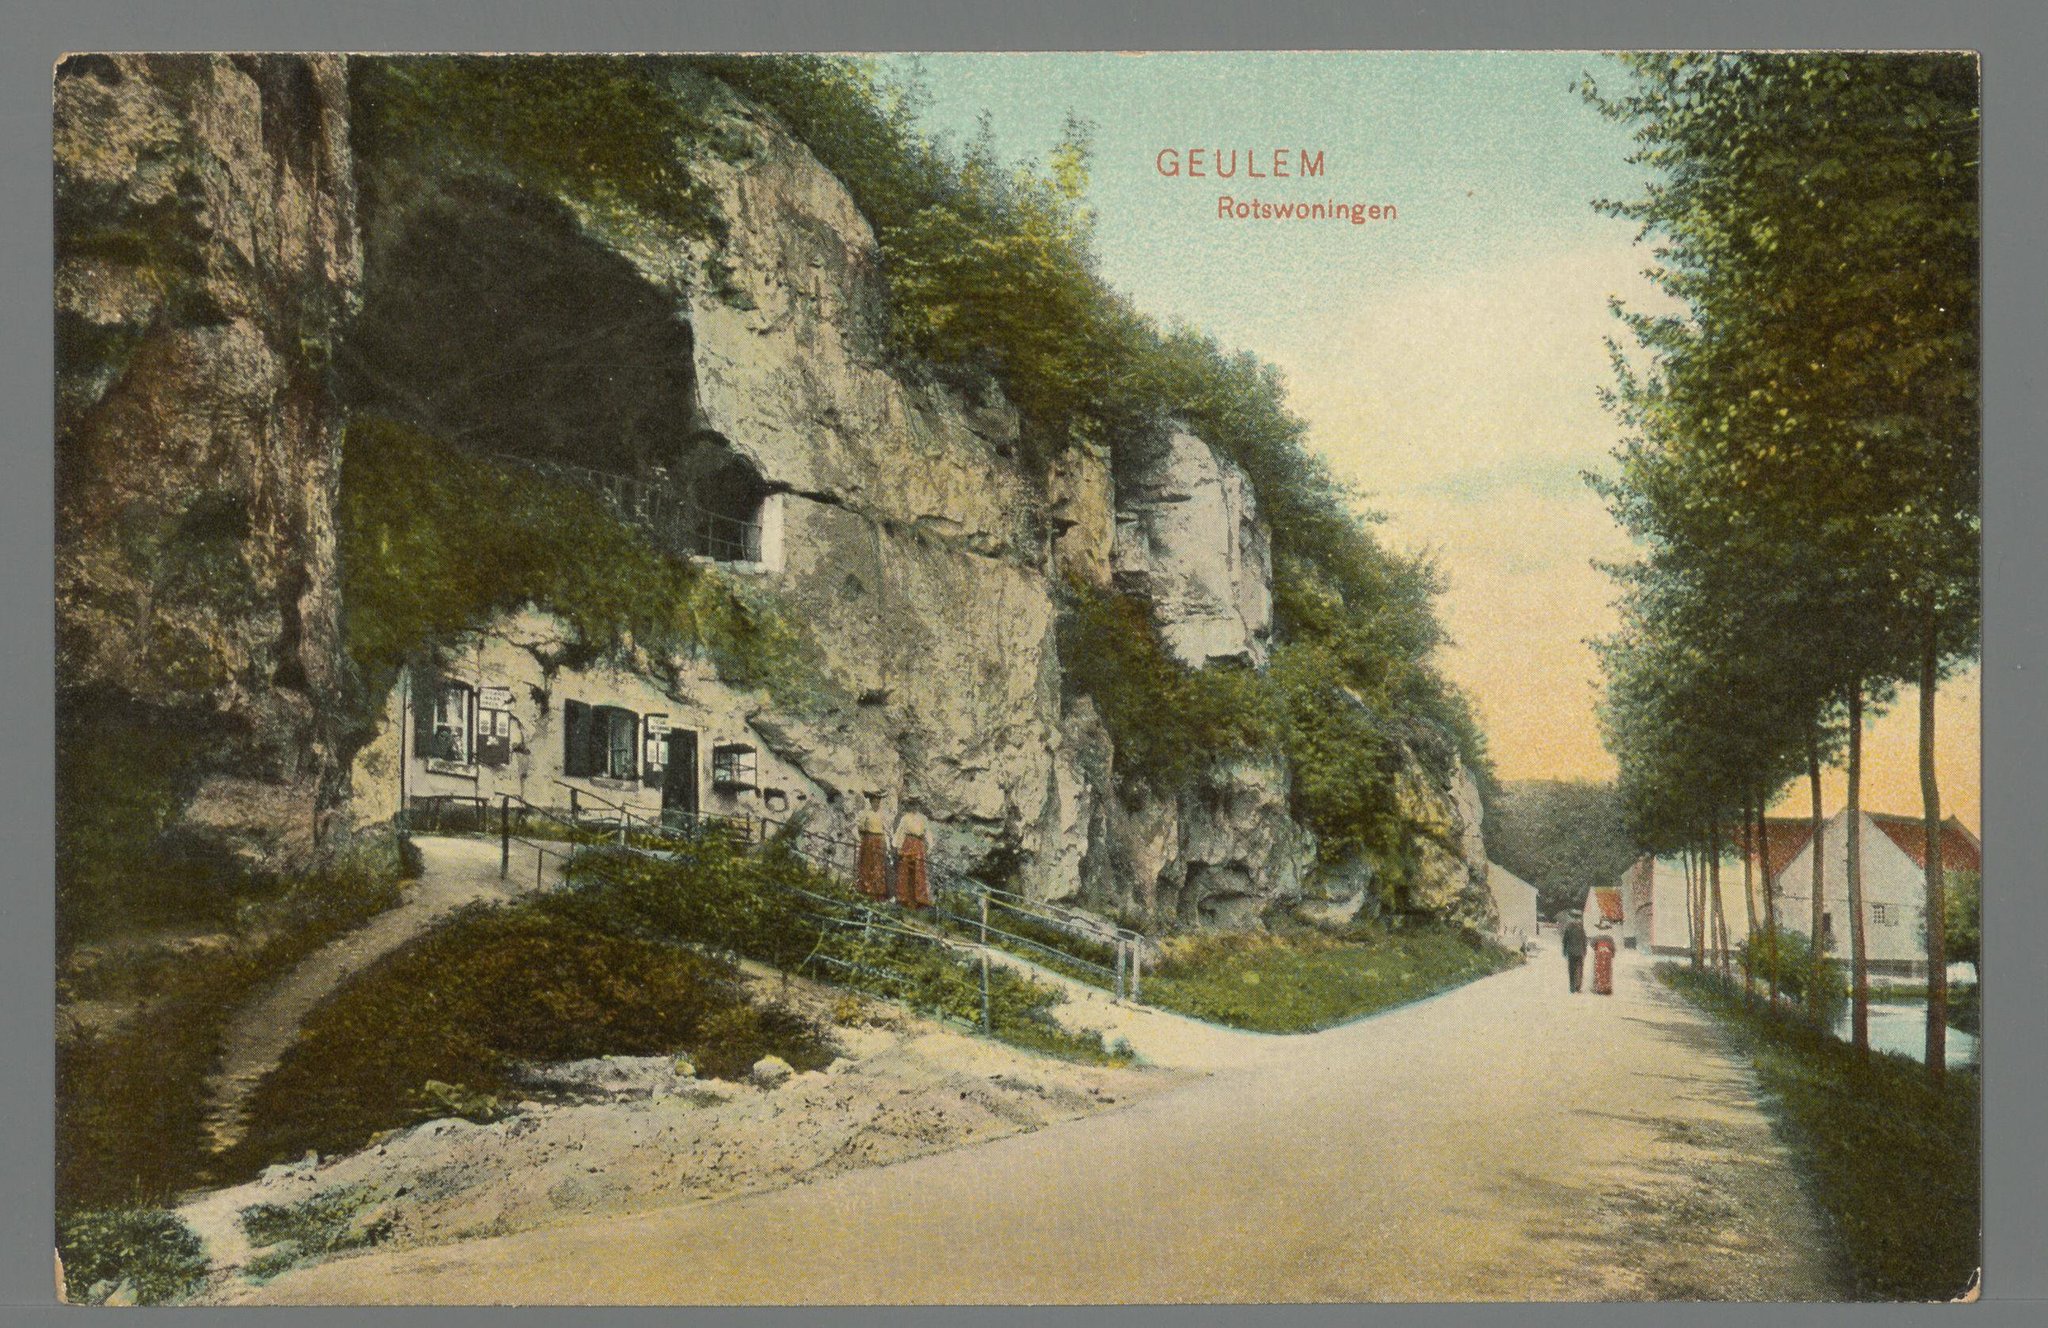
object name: photomechanical print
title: Geulem. Rotswoningen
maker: Anonymous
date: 1907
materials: cardboard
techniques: lithograph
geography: geulhem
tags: housing, cave, grotto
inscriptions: date